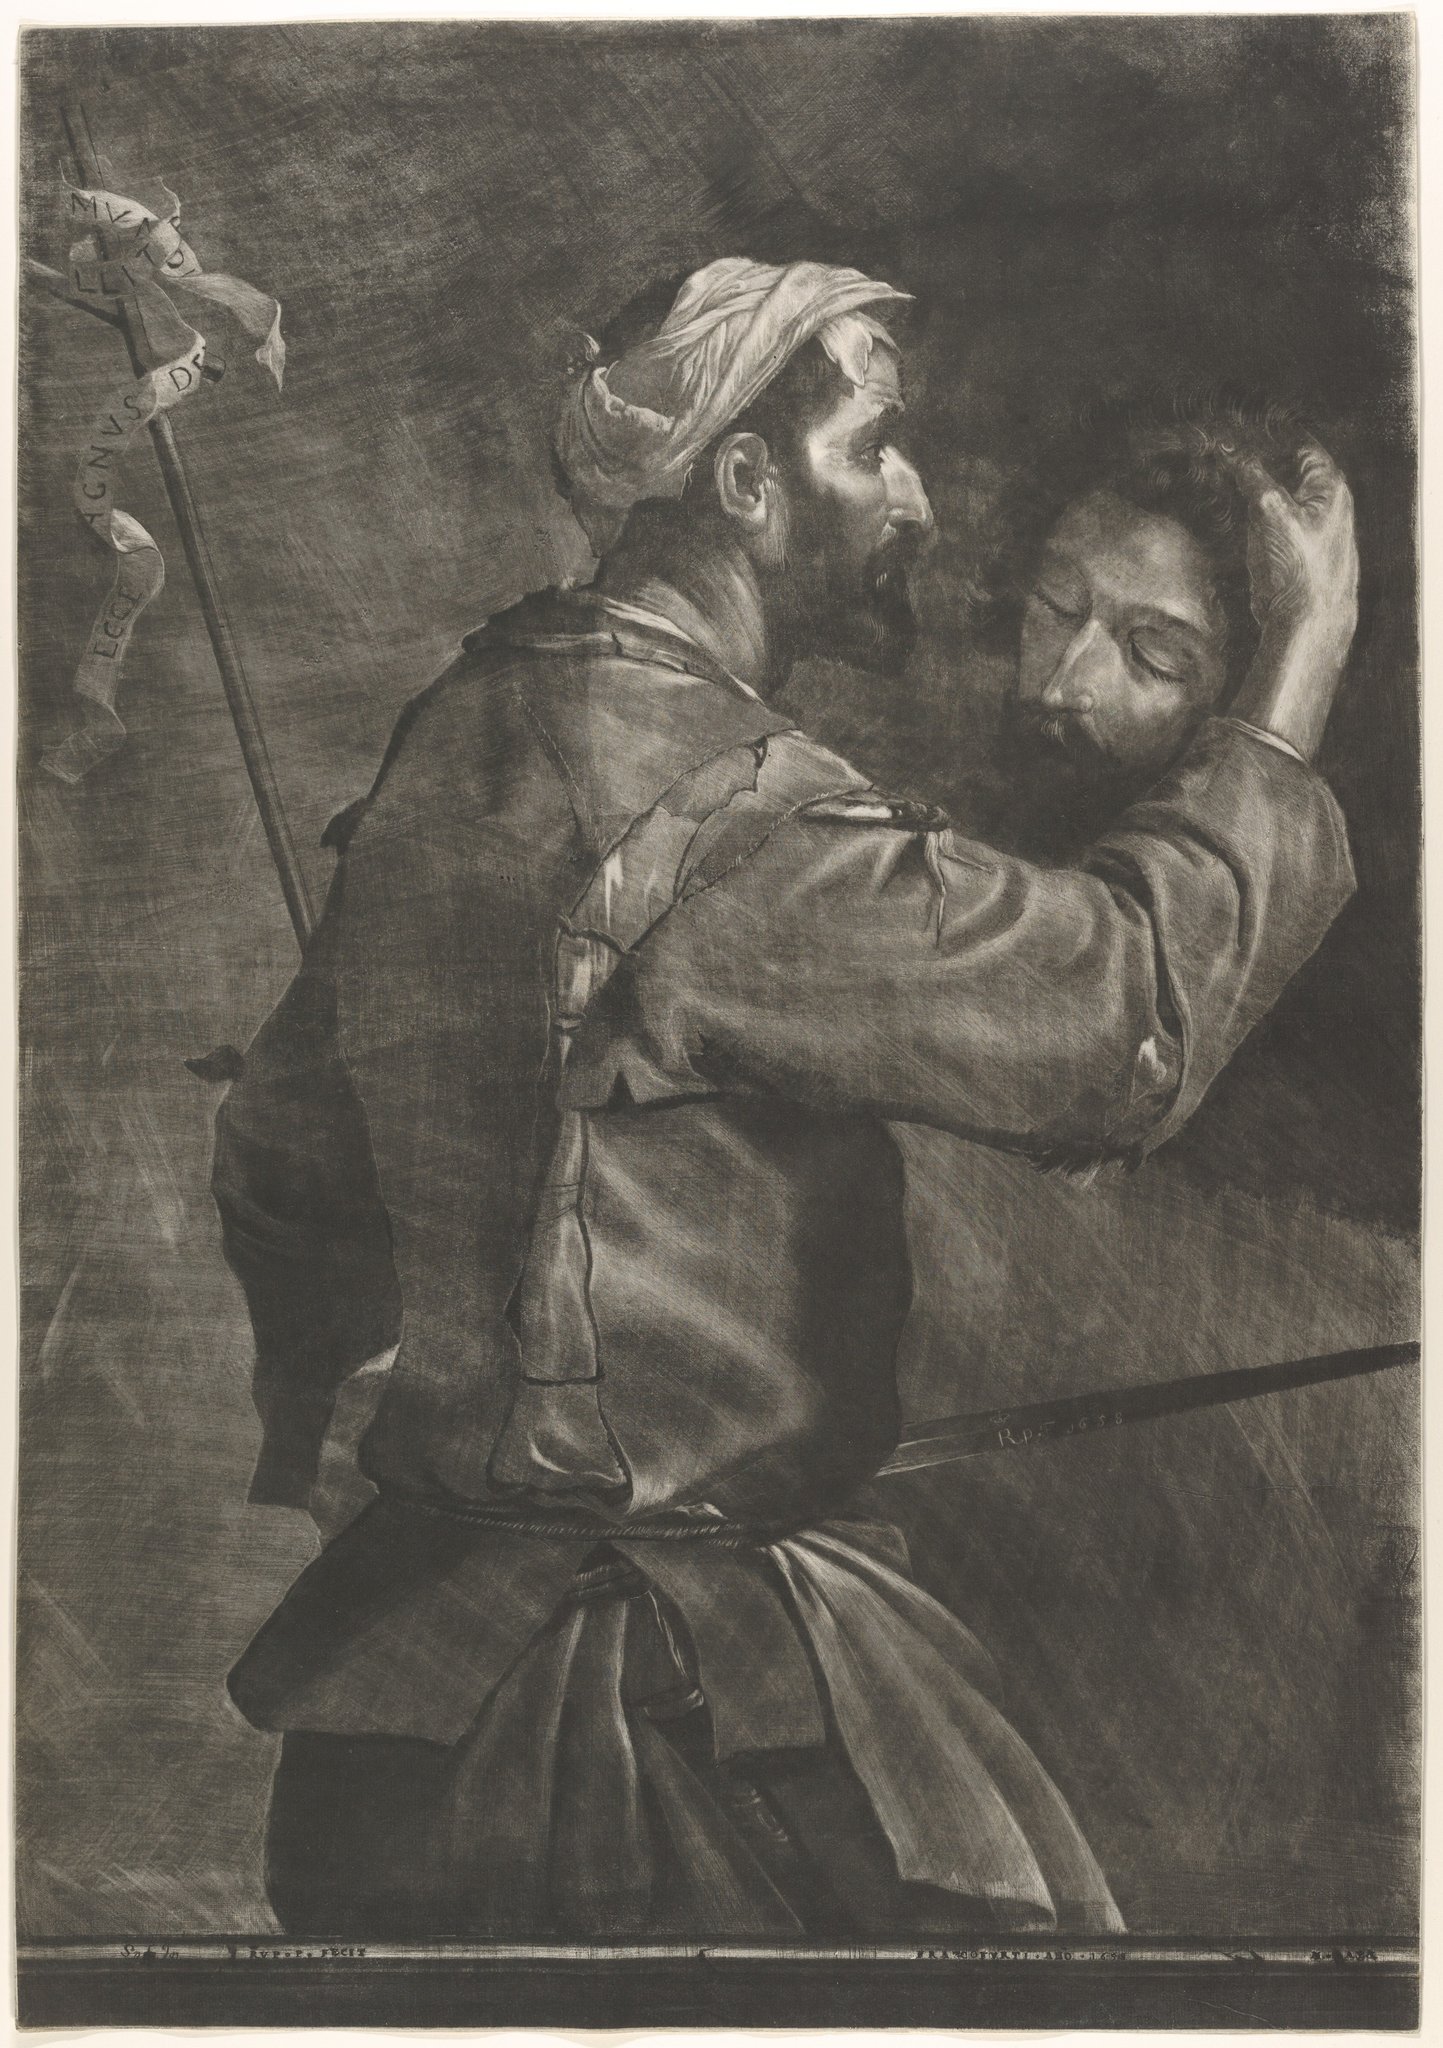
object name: print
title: The Great Executioner with the Head of Saint John the Baptist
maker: prince rupert of the rhine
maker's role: artist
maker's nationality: bohemian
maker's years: 1619-1682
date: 1658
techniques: engraving, mezzotint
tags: heads,men,saint john the baptist